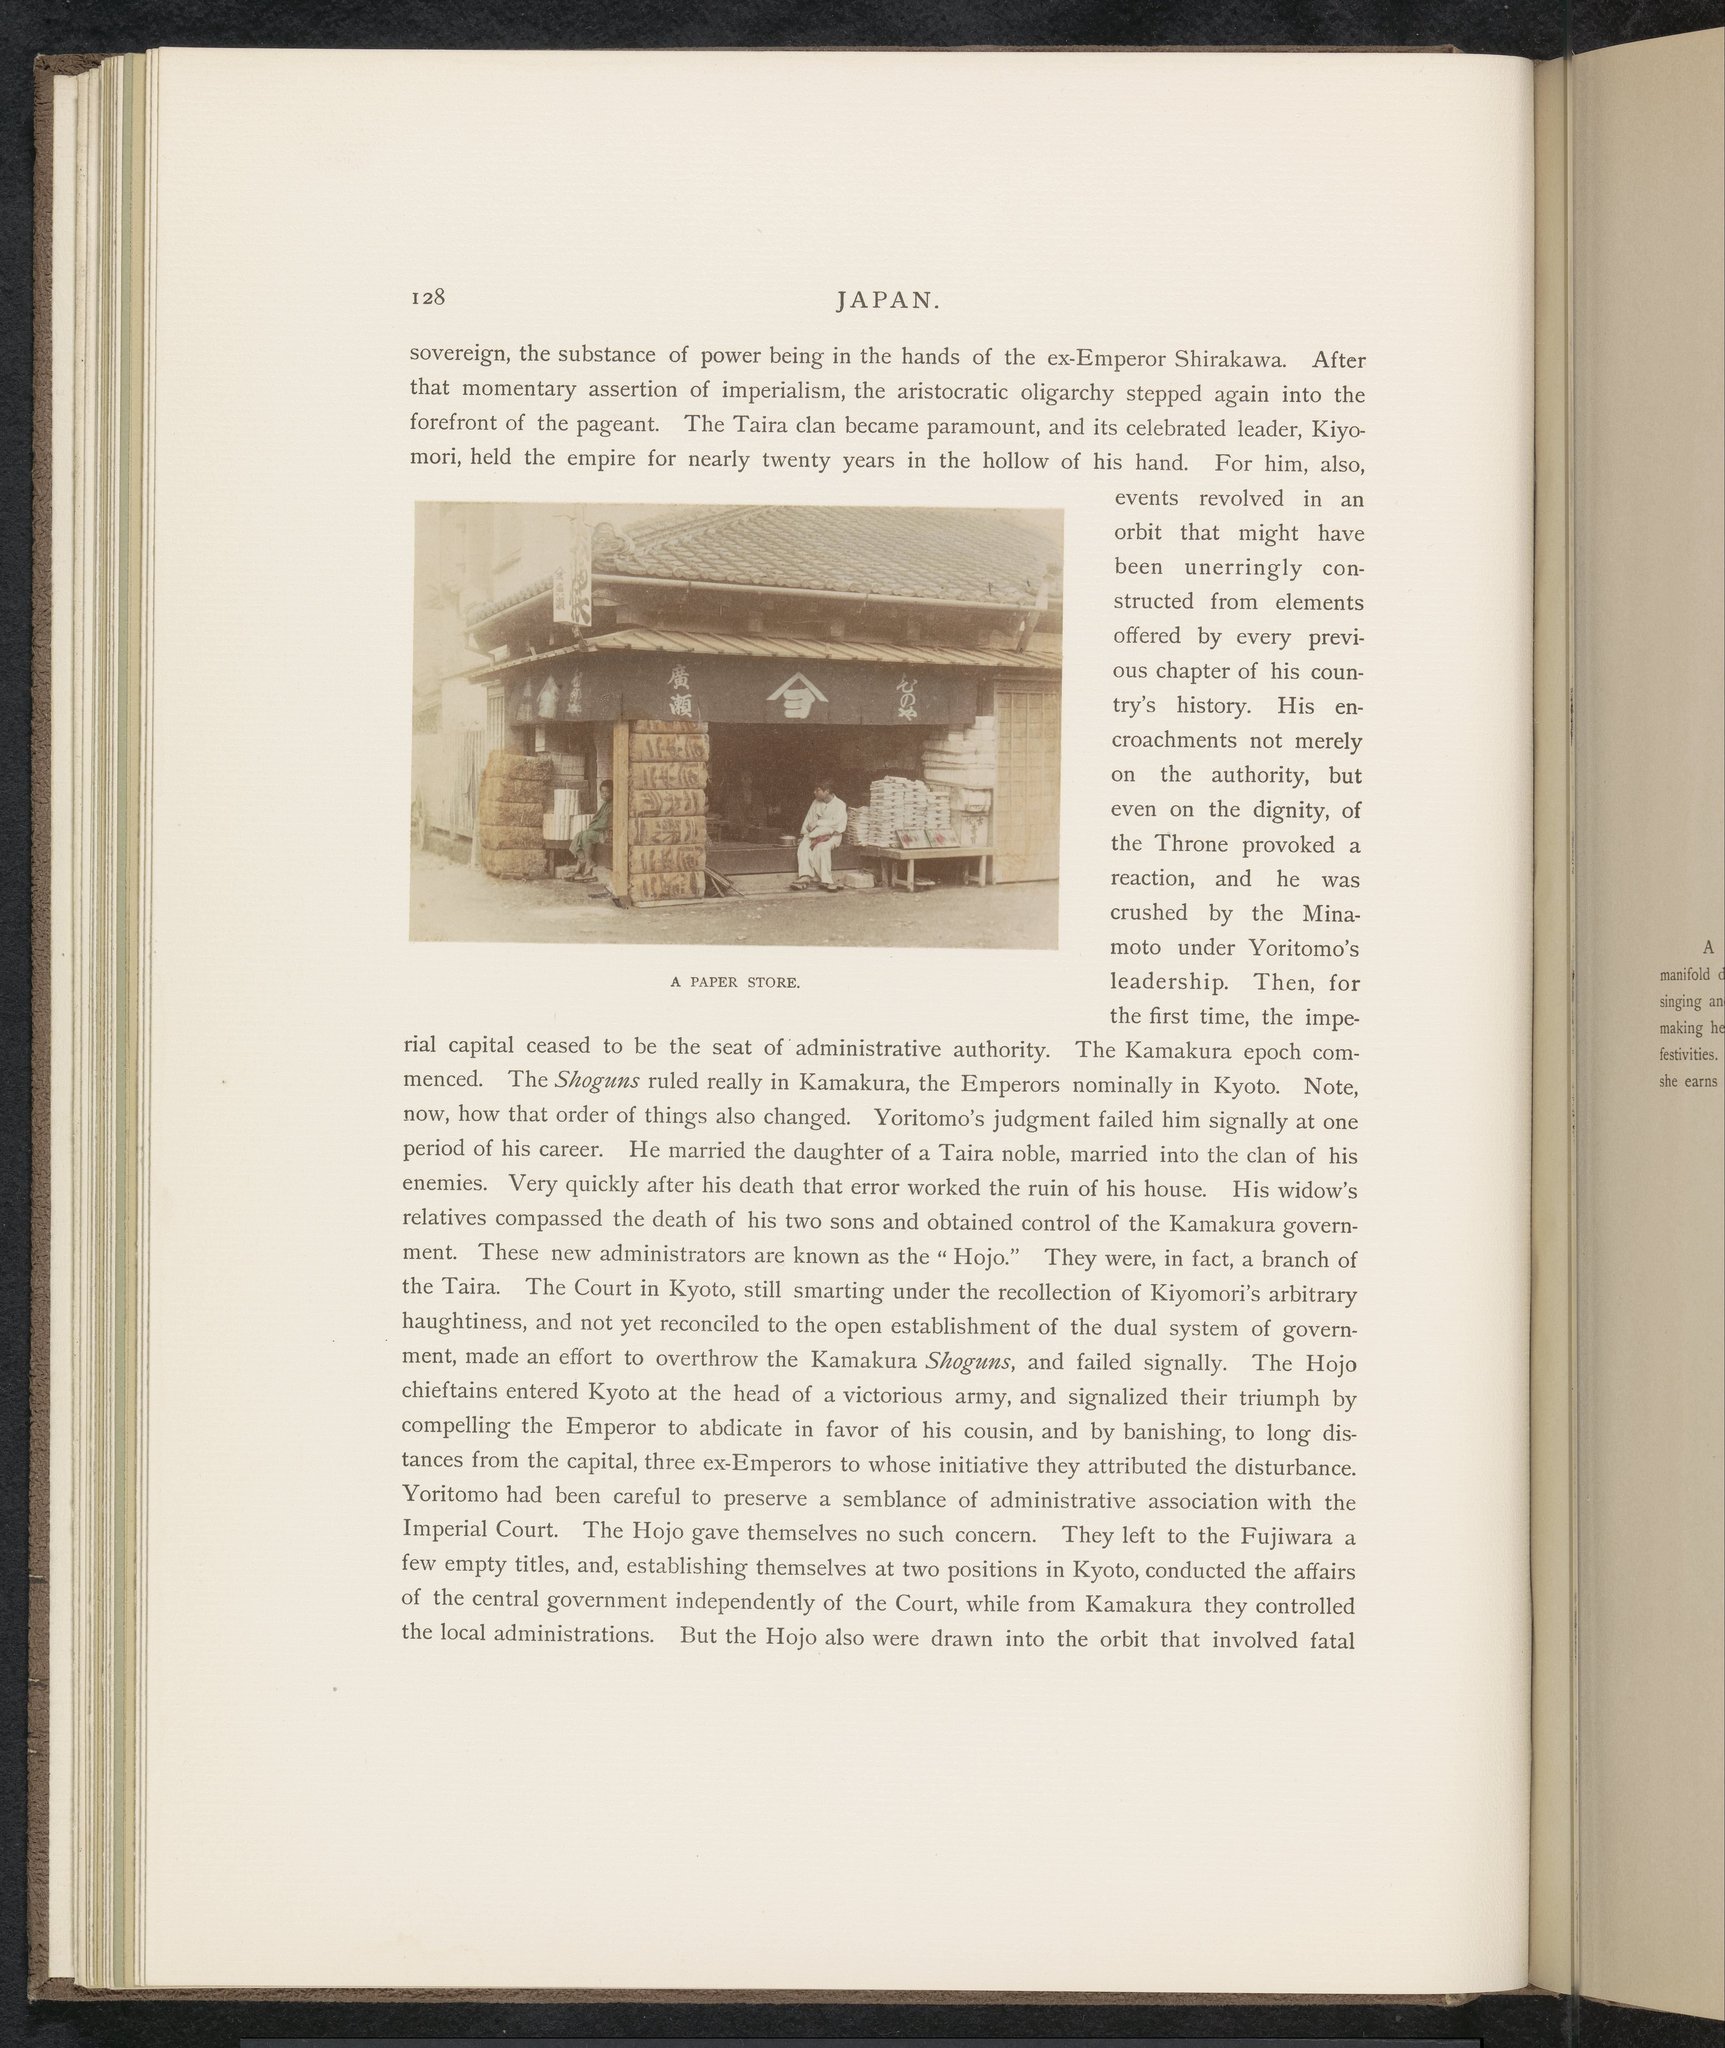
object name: photograph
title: A paper store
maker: Anonymous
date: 1887-1897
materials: photographic support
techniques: albumen print, hand coloring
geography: japan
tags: shop, store, paper (writing material)